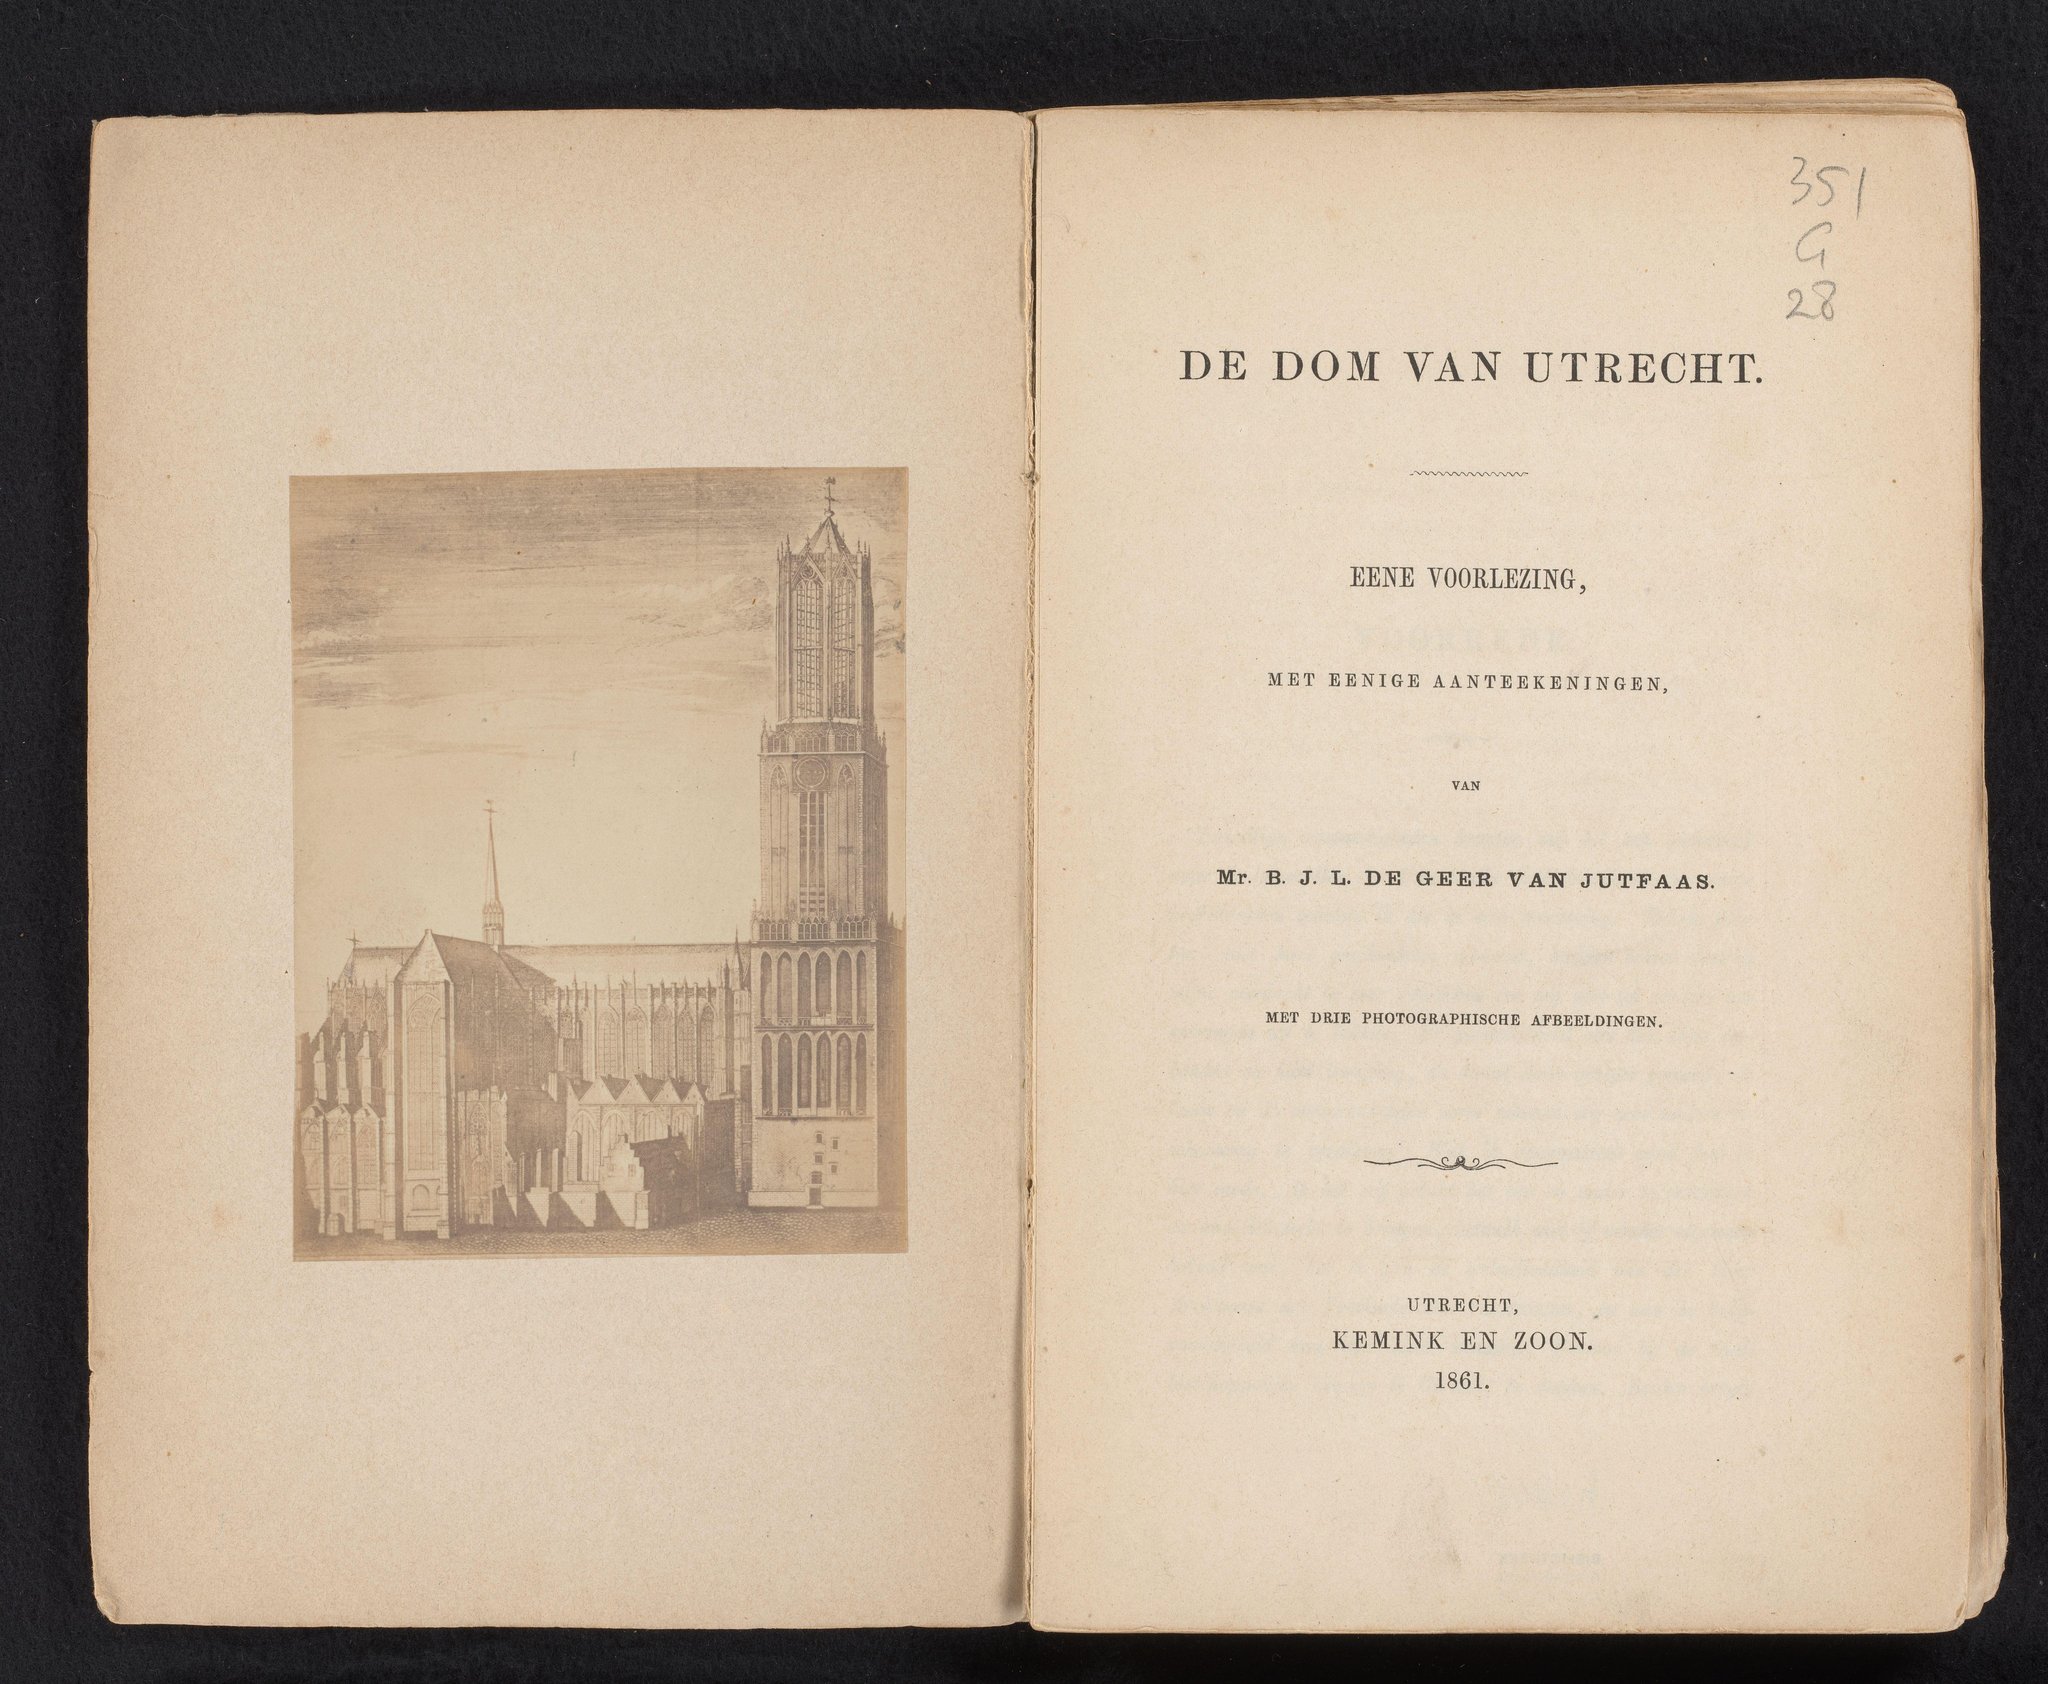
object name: photograph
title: Fotoreproductie van een tekening van de dom van Utrecht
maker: Anonymous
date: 1856-1861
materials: paper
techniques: albumen print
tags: drawing, church (exterior)